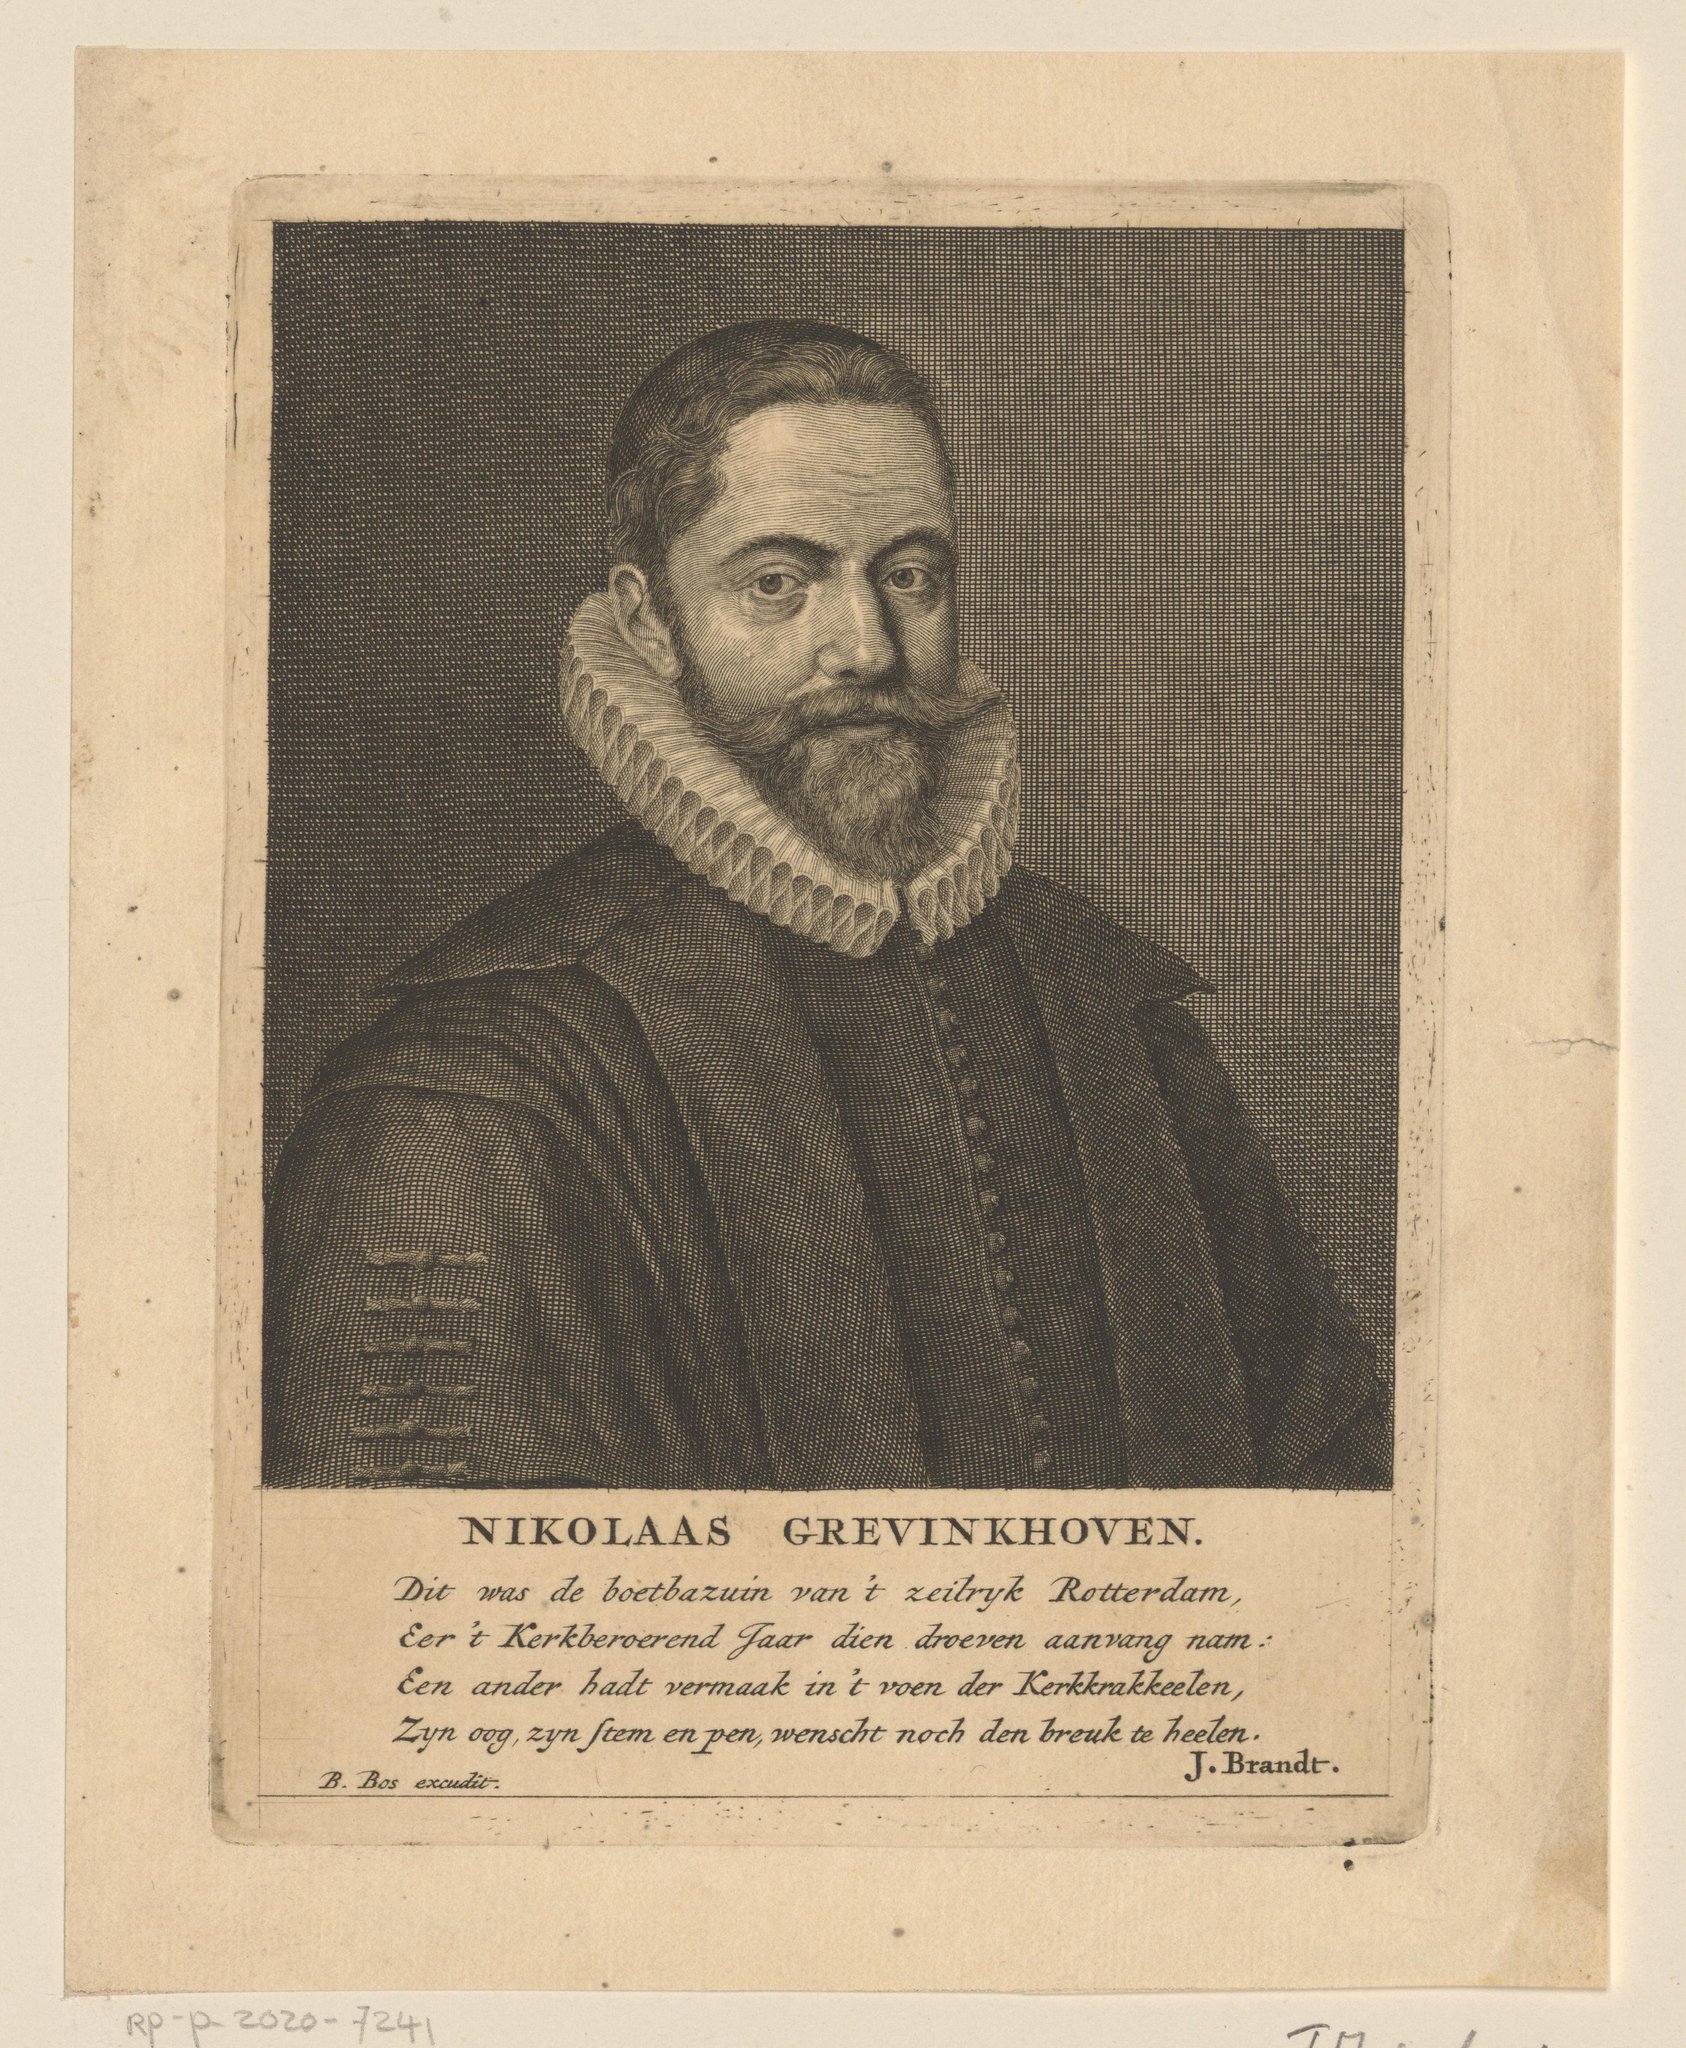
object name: book illustration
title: Portret van Nicolaas Grevinchoven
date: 1704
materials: paper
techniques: engraving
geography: rotterdam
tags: rotterdam, theologian, historical persons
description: Prent uit: Brandt, Geeraert. G. Brandts Historie der reformatie, en andere kerkelyke geschiedenissen, in en ontrent de Nederlanden. Rotterdam: Barent Bos, 1704, dl. 3, p. 748.